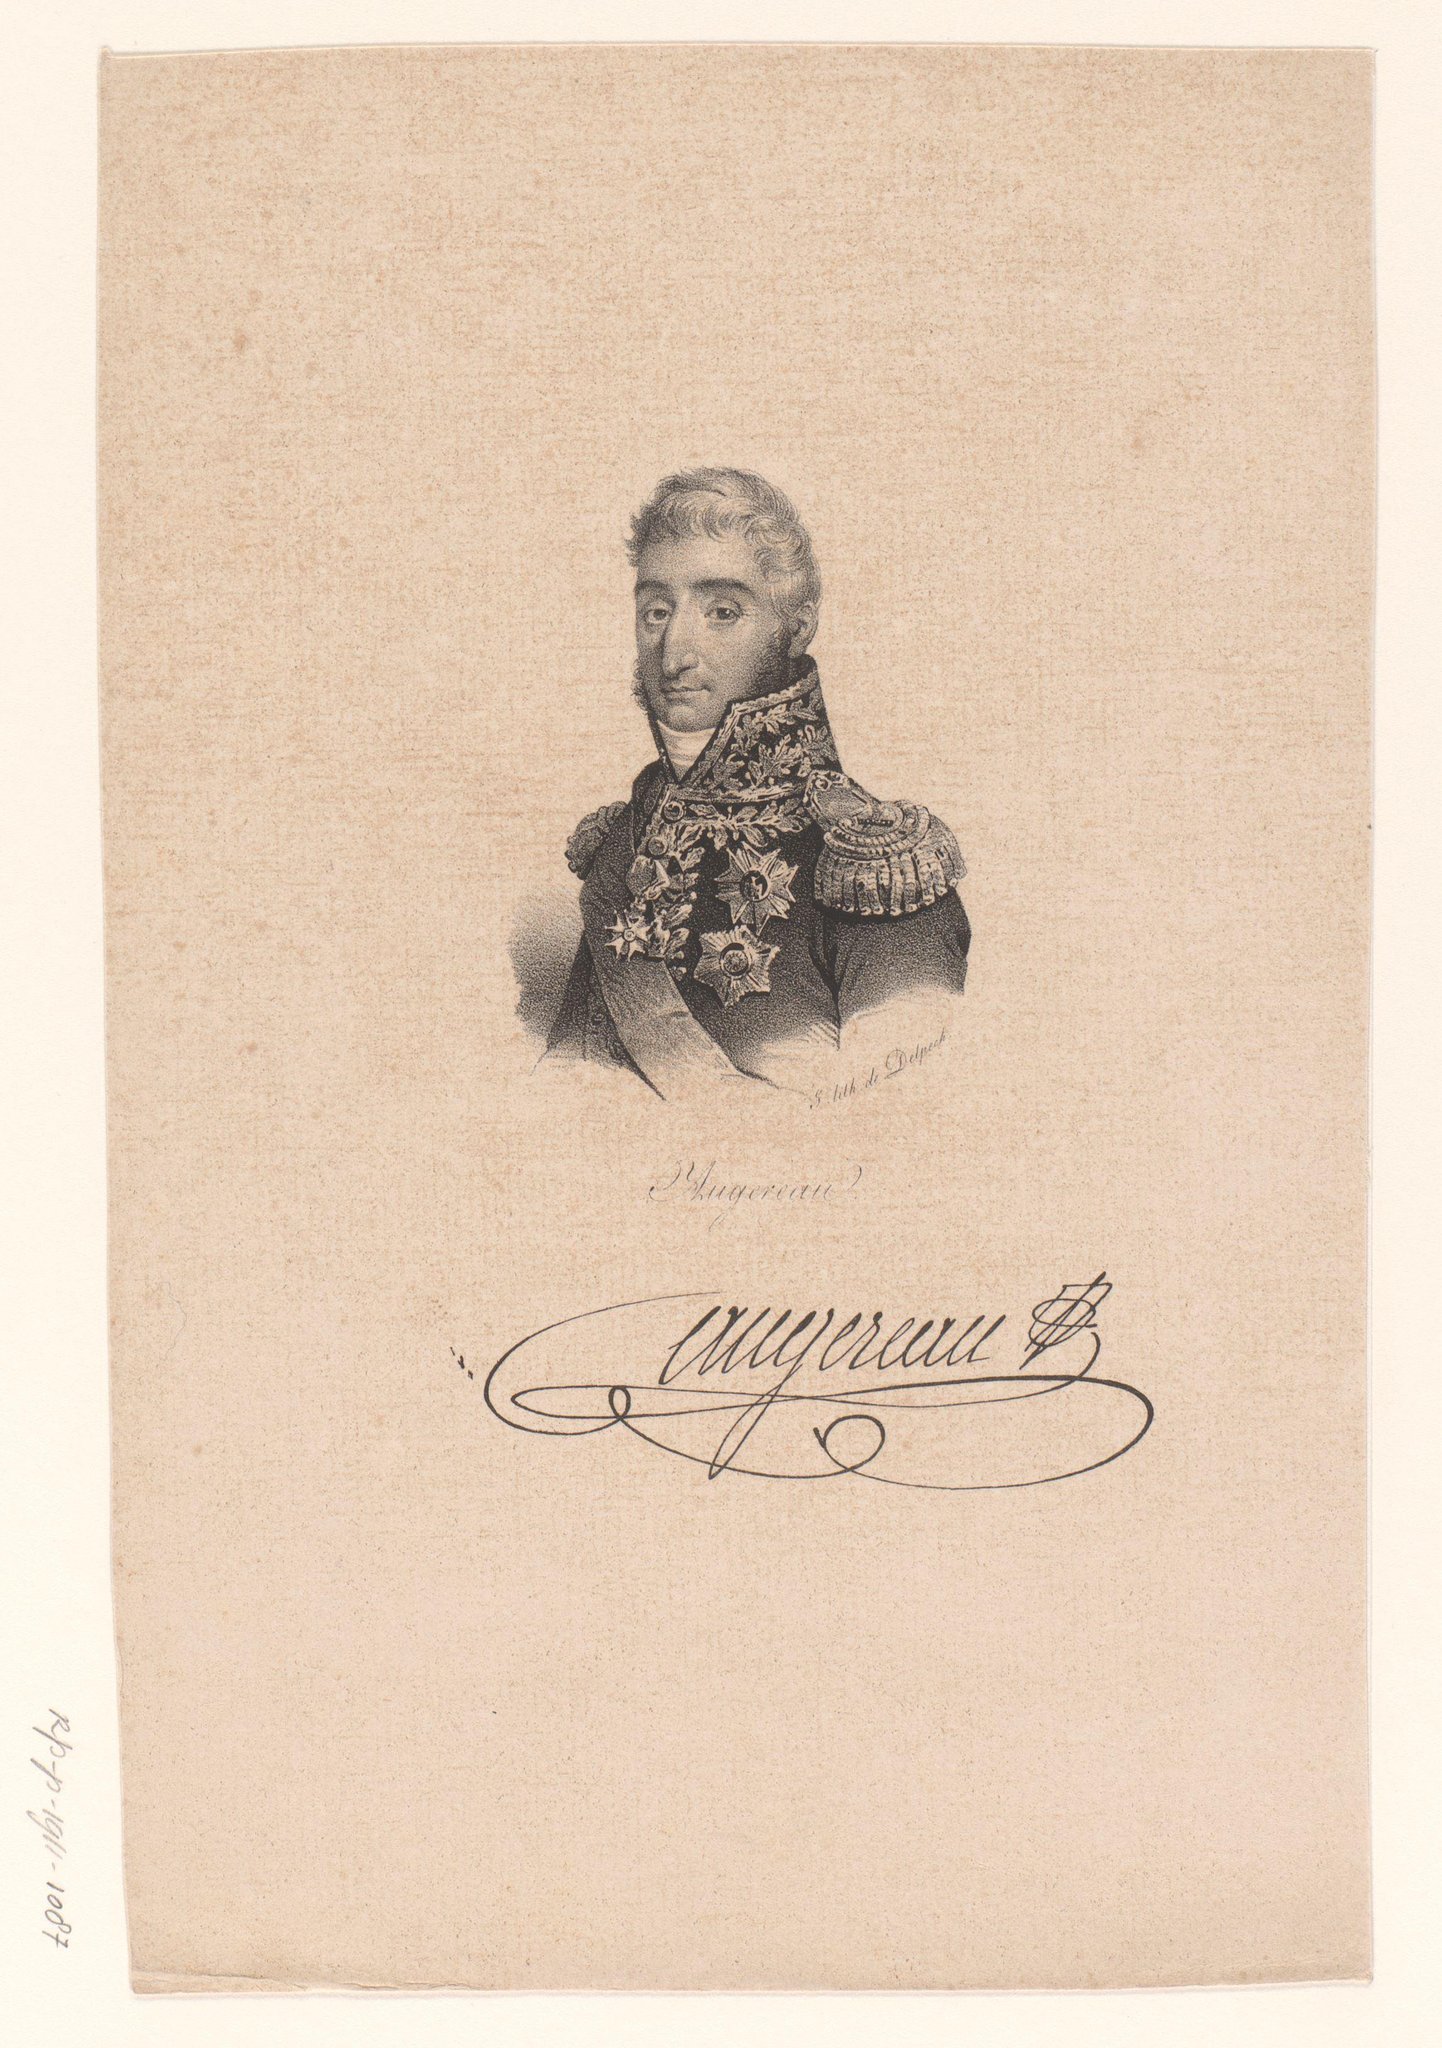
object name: print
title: Portret van Pierre Augereau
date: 1818-1842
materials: paper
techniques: lithograph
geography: paris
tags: paris, historical persons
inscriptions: collector's mark: Lugt 2228a